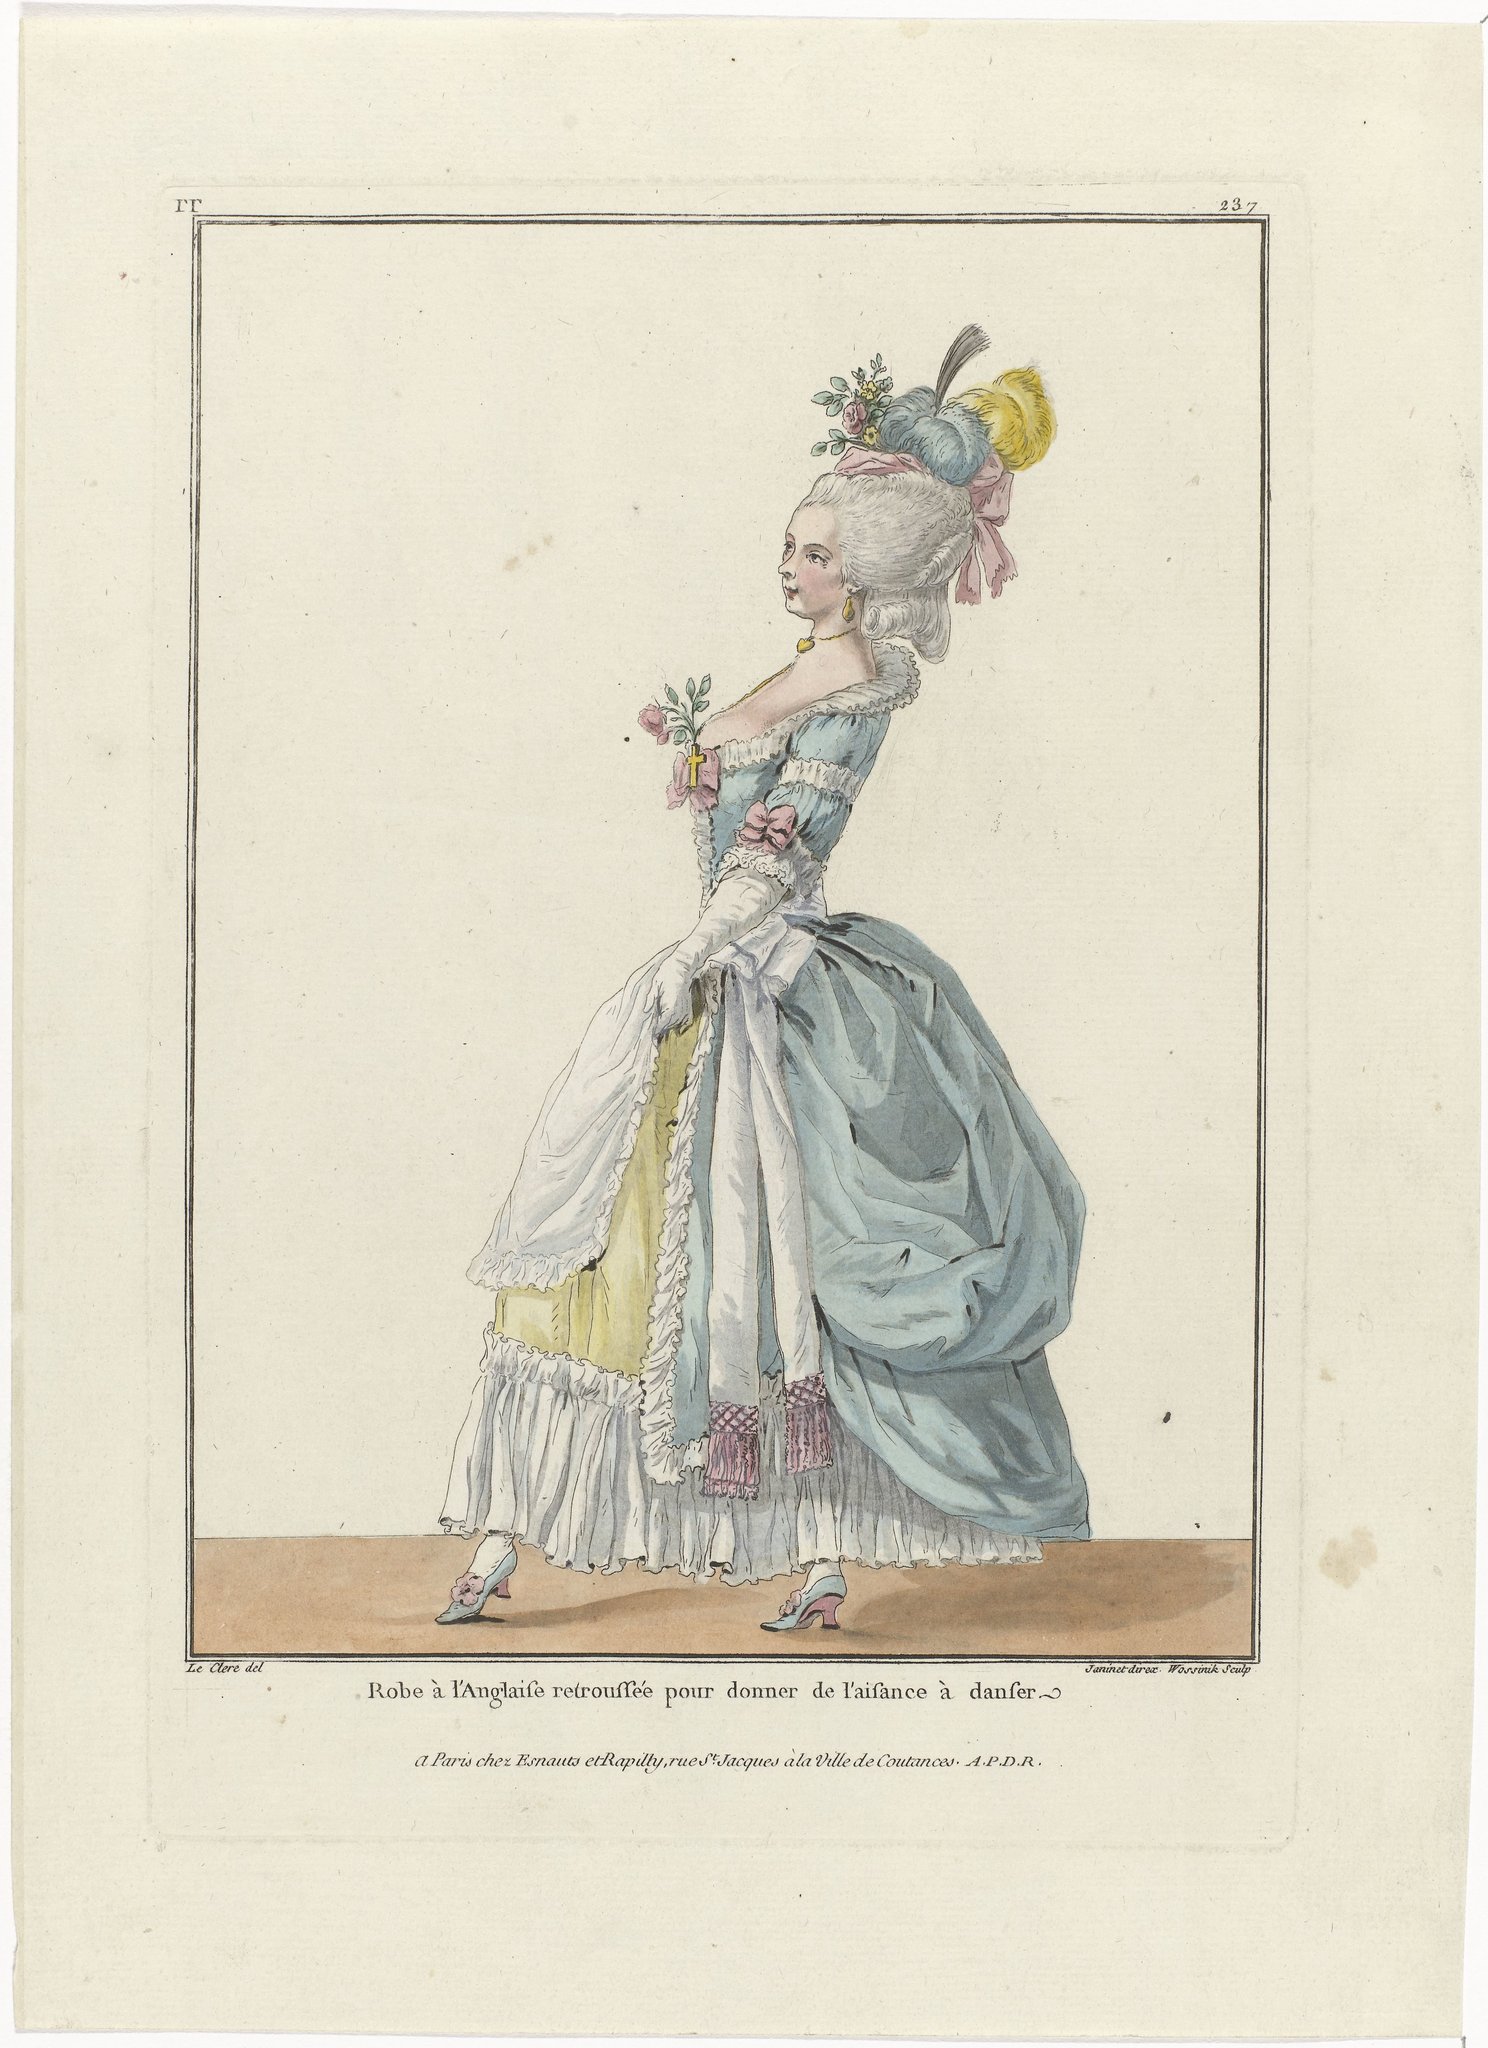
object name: fashion print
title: Gallerie des Modes et Costumes Français, 1782, 34e Cahier (bis), 31e Suite, rr.237 : Robe à l'Anglais (...).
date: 1782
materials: paper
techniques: engraving, hand coloring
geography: paris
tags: corsage (+ women's clothes), ear-rings (+ women's clothes), gloves, mittens (long gloves) (+ women's clothes), dress, gown: robe à l'anglaise (+ women's clothes), fashion plates, shoes, sandals (+ women's clothes), apron (+ women's clothes), necklace (+ women's clothes)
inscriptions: caption: ‘Robe à l'Anglaise retroussée pour donner d l'aisance à danser.’, address: ‘A Paris chez Esnauts et Rapilly, rue St. Jaques à la Ville de Coutances. A.P.D.R.’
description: 'Robe à l'Anglaise' met 'manches en sabot', afgezet met een strik. Sierschort. Om het middel een ceintuur met franjes aan de uiteinden. Onder de rok zijn witte kousen en schoenen met hakken zichtbaar. Het opgekapte haar is versierd met lint, bloemen en veren. Accessoires: oorbellen, collier met hartvormige hanger, corsage van een kruis en een bloem, lange handschoenen. Volgens het onderschrift wordt de japon opgetrokken om het dansen te vergemakkelijken. Prent uit de serie rr. 34e Cahier (bis) des Costumes Français, 31e Suite d'Habillemens à la mode en 1782, Gallerie des Modes et Costumes Français.